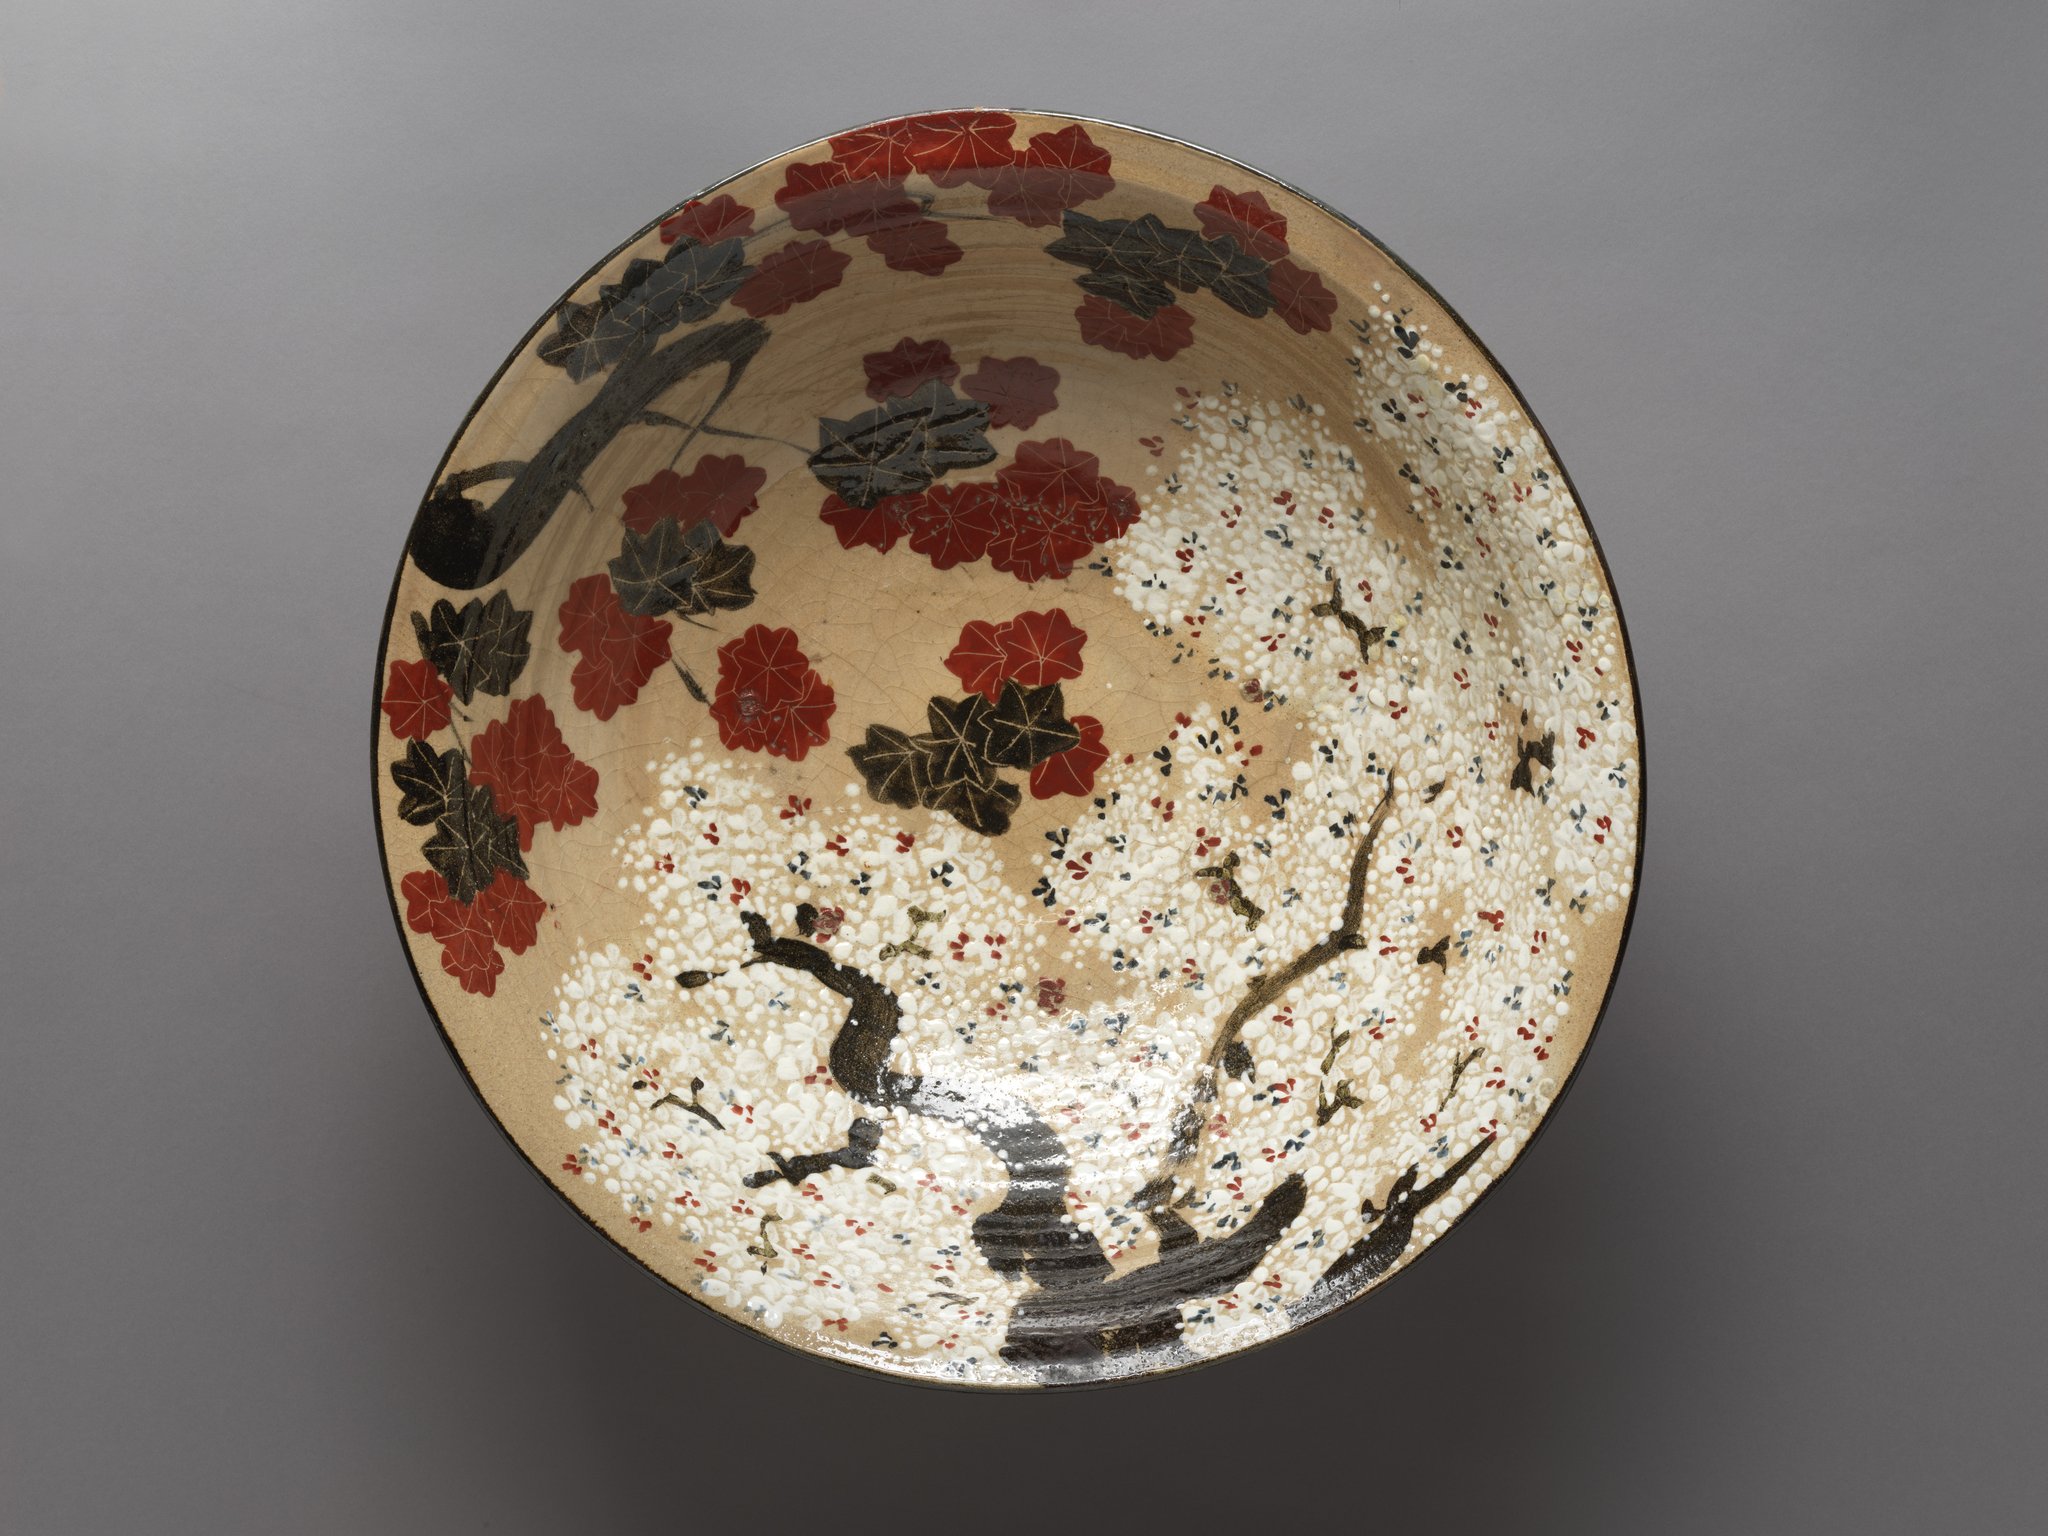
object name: bowl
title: Large Bowl with Cherry Blossoms and Maple Leaves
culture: japanese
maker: takahashi dōhachi iii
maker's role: artist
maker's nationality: japanese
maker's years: 1811-1879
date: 1801-1850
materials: enamel, iron, stoneware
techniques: overglaze, polychrome, underglaze